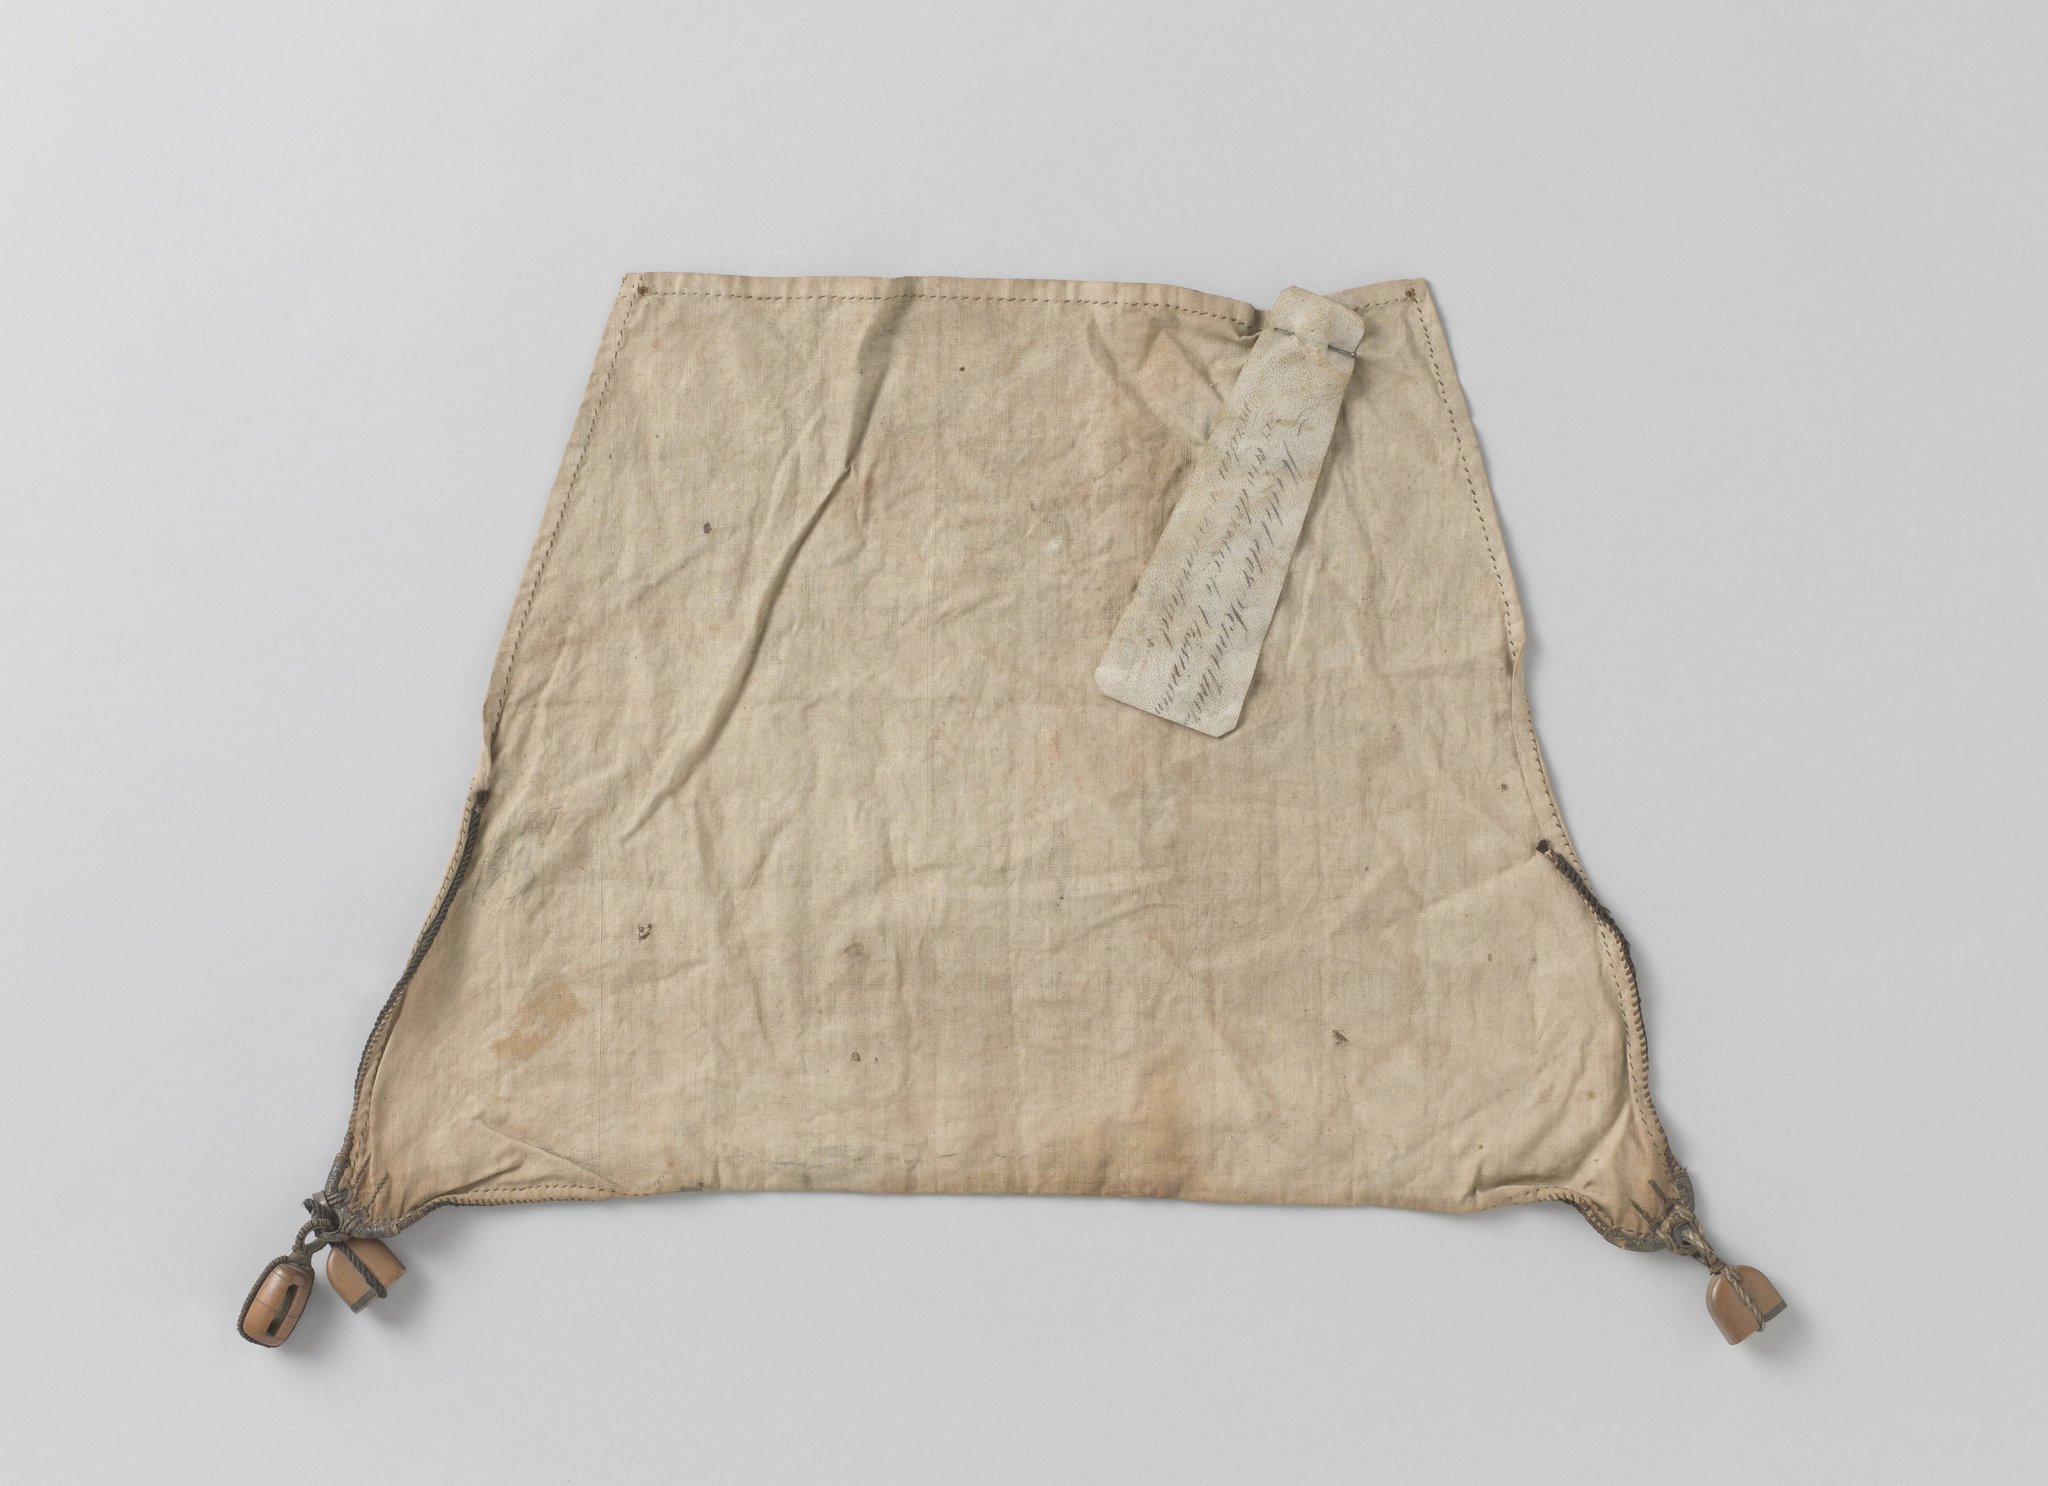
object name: scale model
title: Model van een razeil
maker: Anonymous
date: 1700-1900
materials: textile, wood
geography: flushing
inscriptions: inscription: ‘Model der schoothoorns zoals deze te Vlissingen worden vervaardigd.’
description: Model van een zeiltje met aan de schoothoorn een afwijkend soort geiblokken. Aan de andere kant is nog een extra blok toegevoegd. Aan zeil opschrift op label.